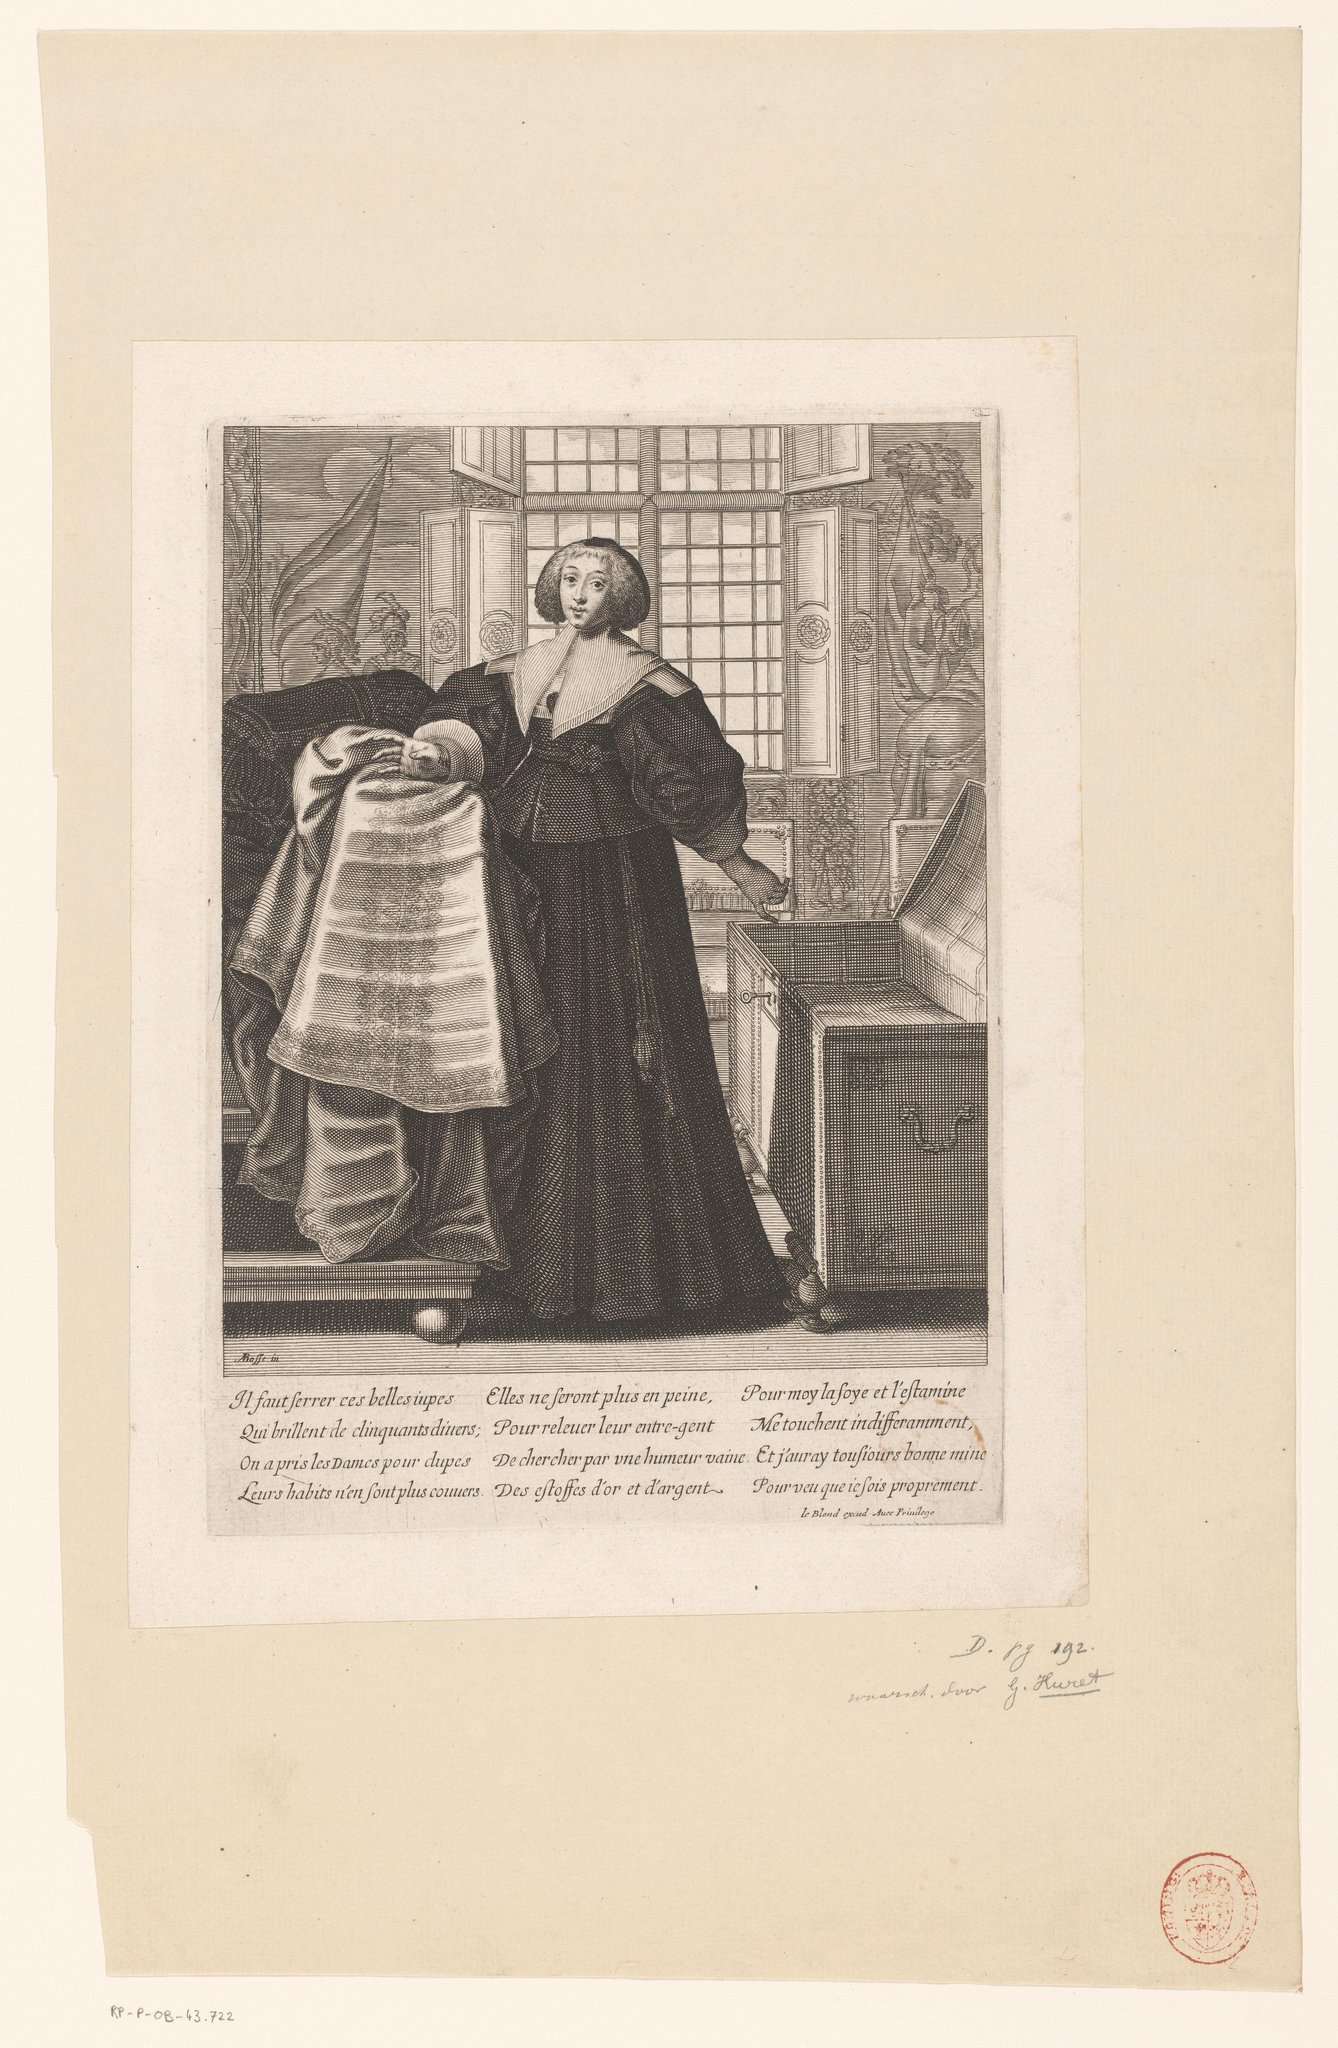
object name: print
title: Franse dame reagerend op het edict van 1633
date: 1633-1670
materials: paper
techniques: engraving, etching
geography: paris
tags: fashion, clothing, chest, coffer, tapestry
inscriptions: collector's mark: Lugt 240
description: In 1633 legde Lodewijk XIII de adel op zich een soberder manier van kleden aan te meten. Het dragen van kant aan kragen, manchetten en canons werd verboden.